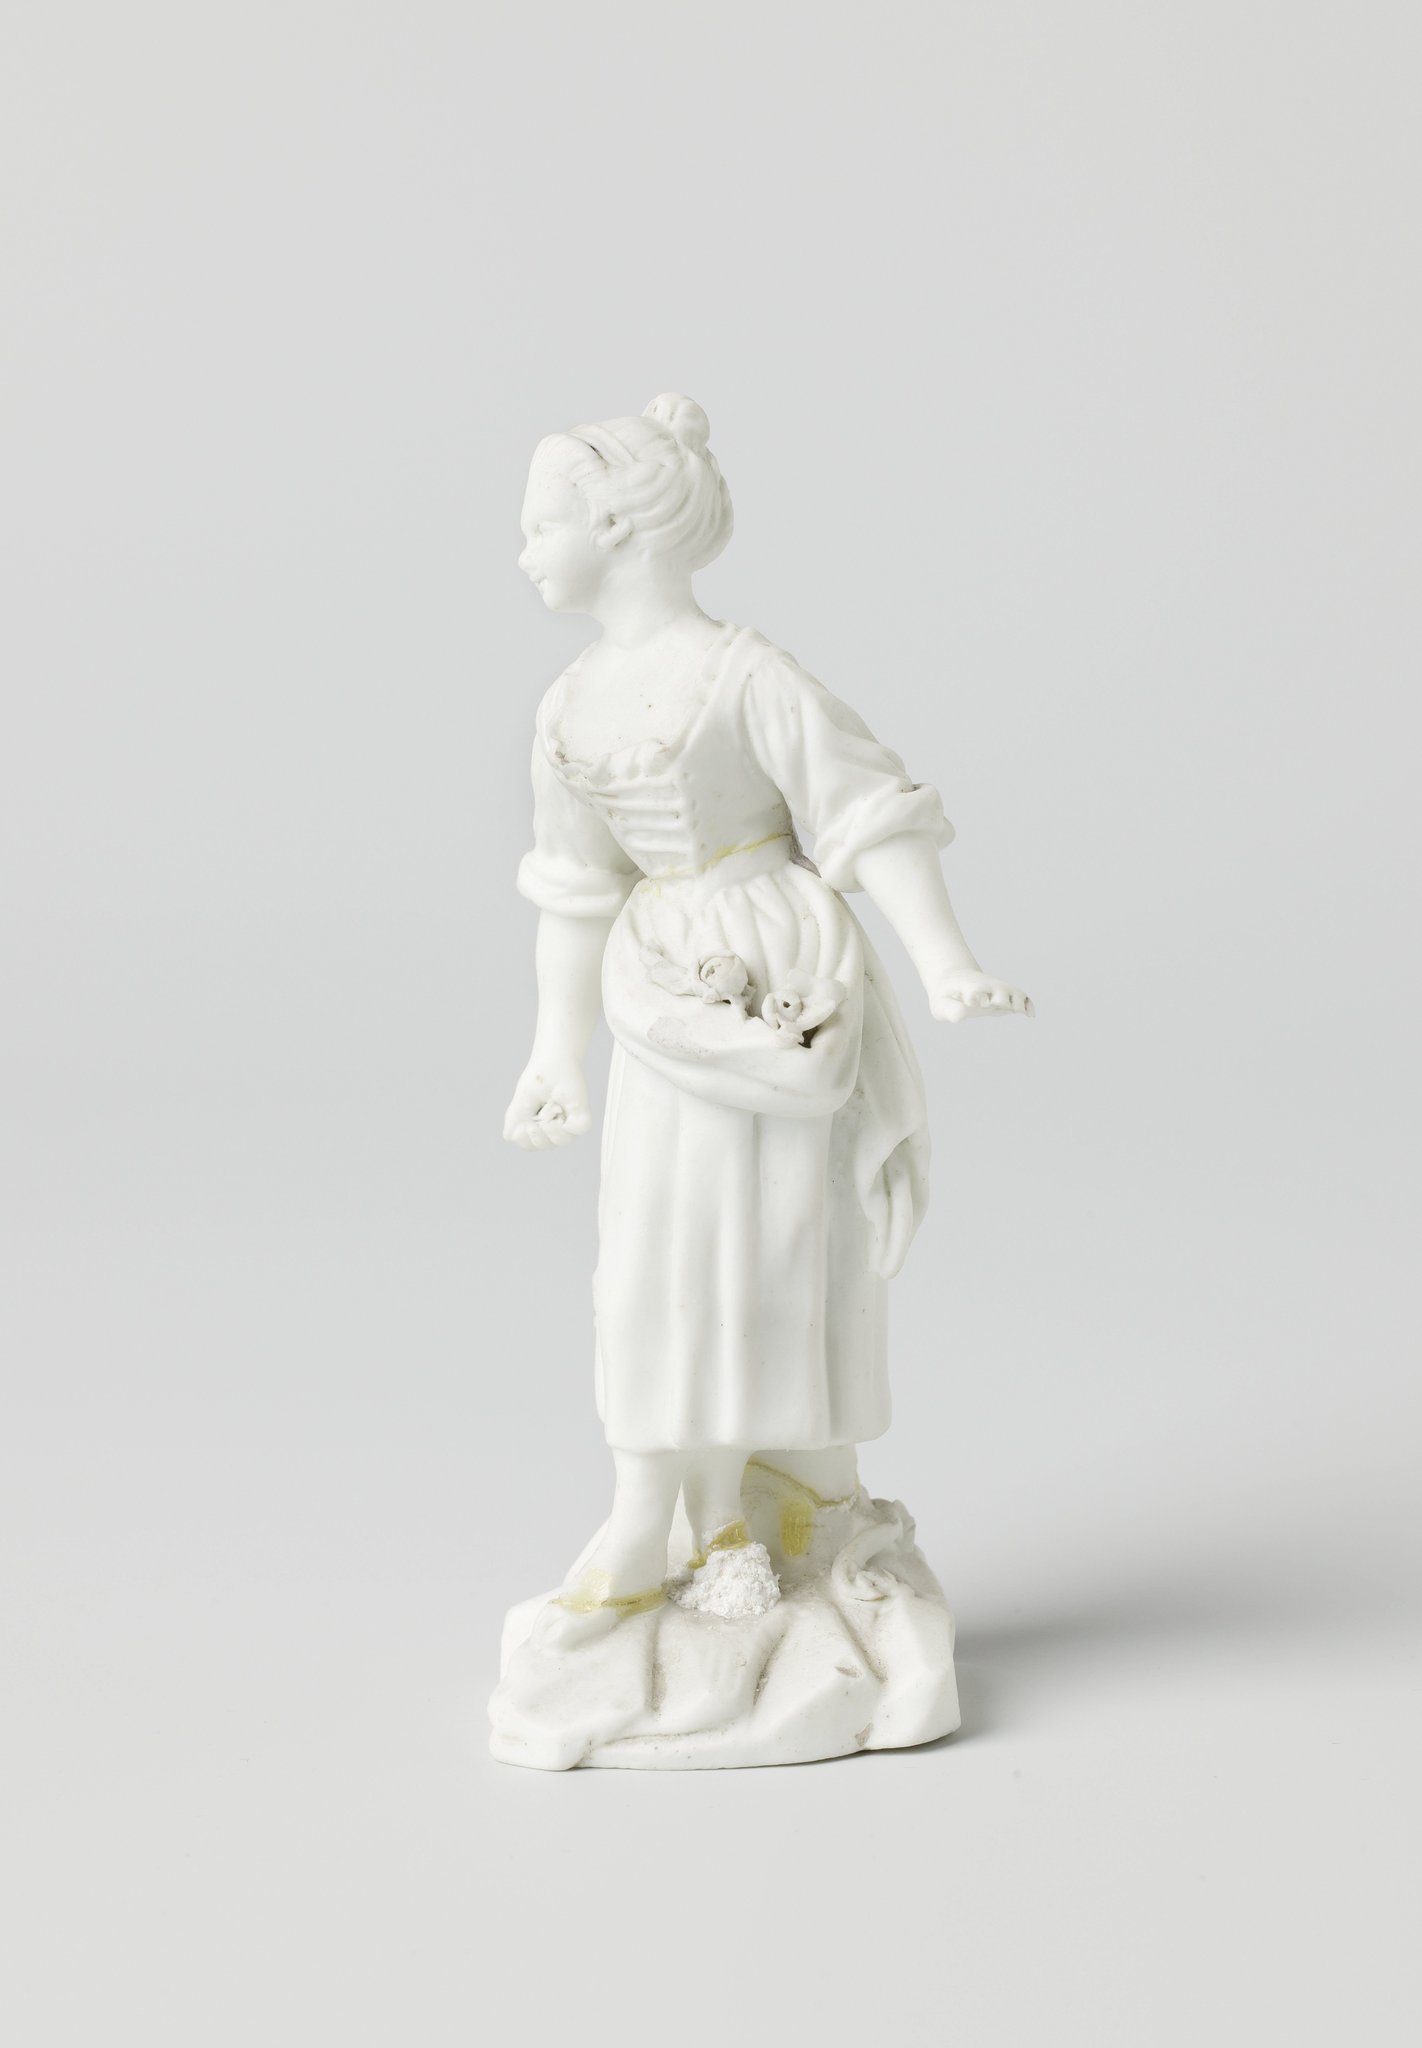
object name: figure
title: Figuur van een herderin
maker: Anonymous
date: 1500-1950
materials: earthenware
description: Beeldhouwwerk, figuur van een herderin, van wit ongeglazuurd porselein, z.g. biscuit.